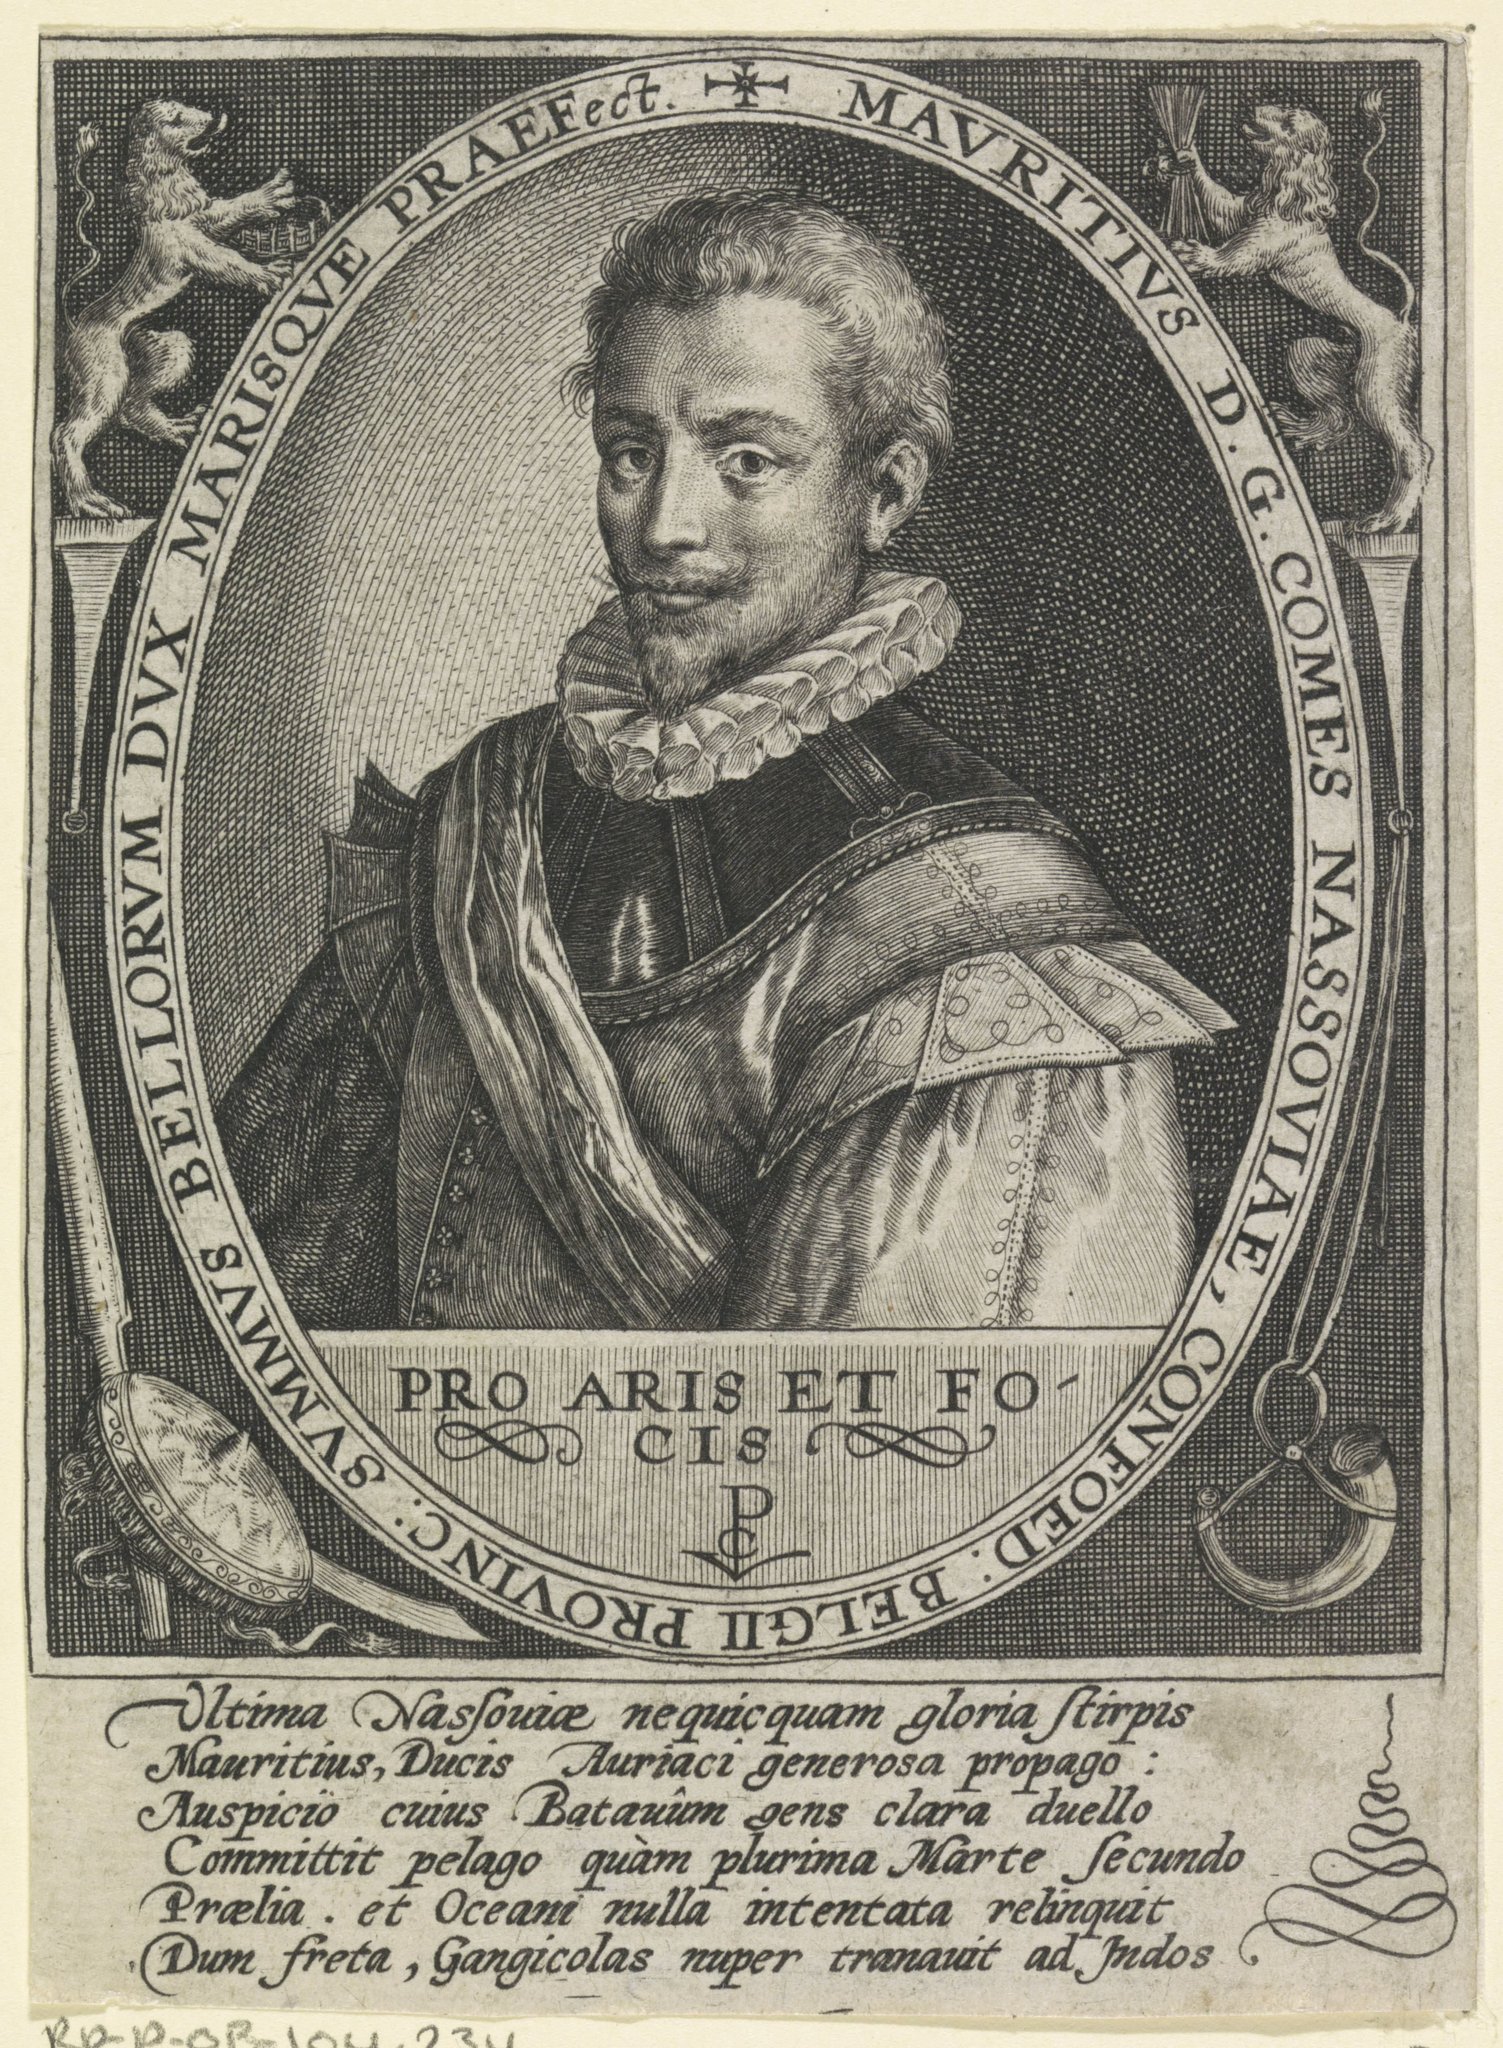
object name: print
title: Portret van Maurits, prins van Oranje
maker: crispijn van de passe (i)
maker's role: draughtsman, print maker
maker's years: 1564-1637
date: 1580-1637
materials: paper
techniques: engraving, etching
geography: low countries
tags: the hague, maurice (prince of orange)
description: Portret van Maurits in een ovaal met randschrift en een balustrade met een devies. Daar omheen een aantal allegorische objecten. In de ondermarge zes regels Latijnse tekst.